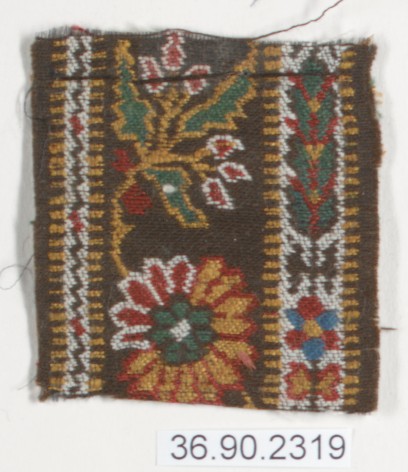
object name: border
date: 1801-1900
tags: flowers